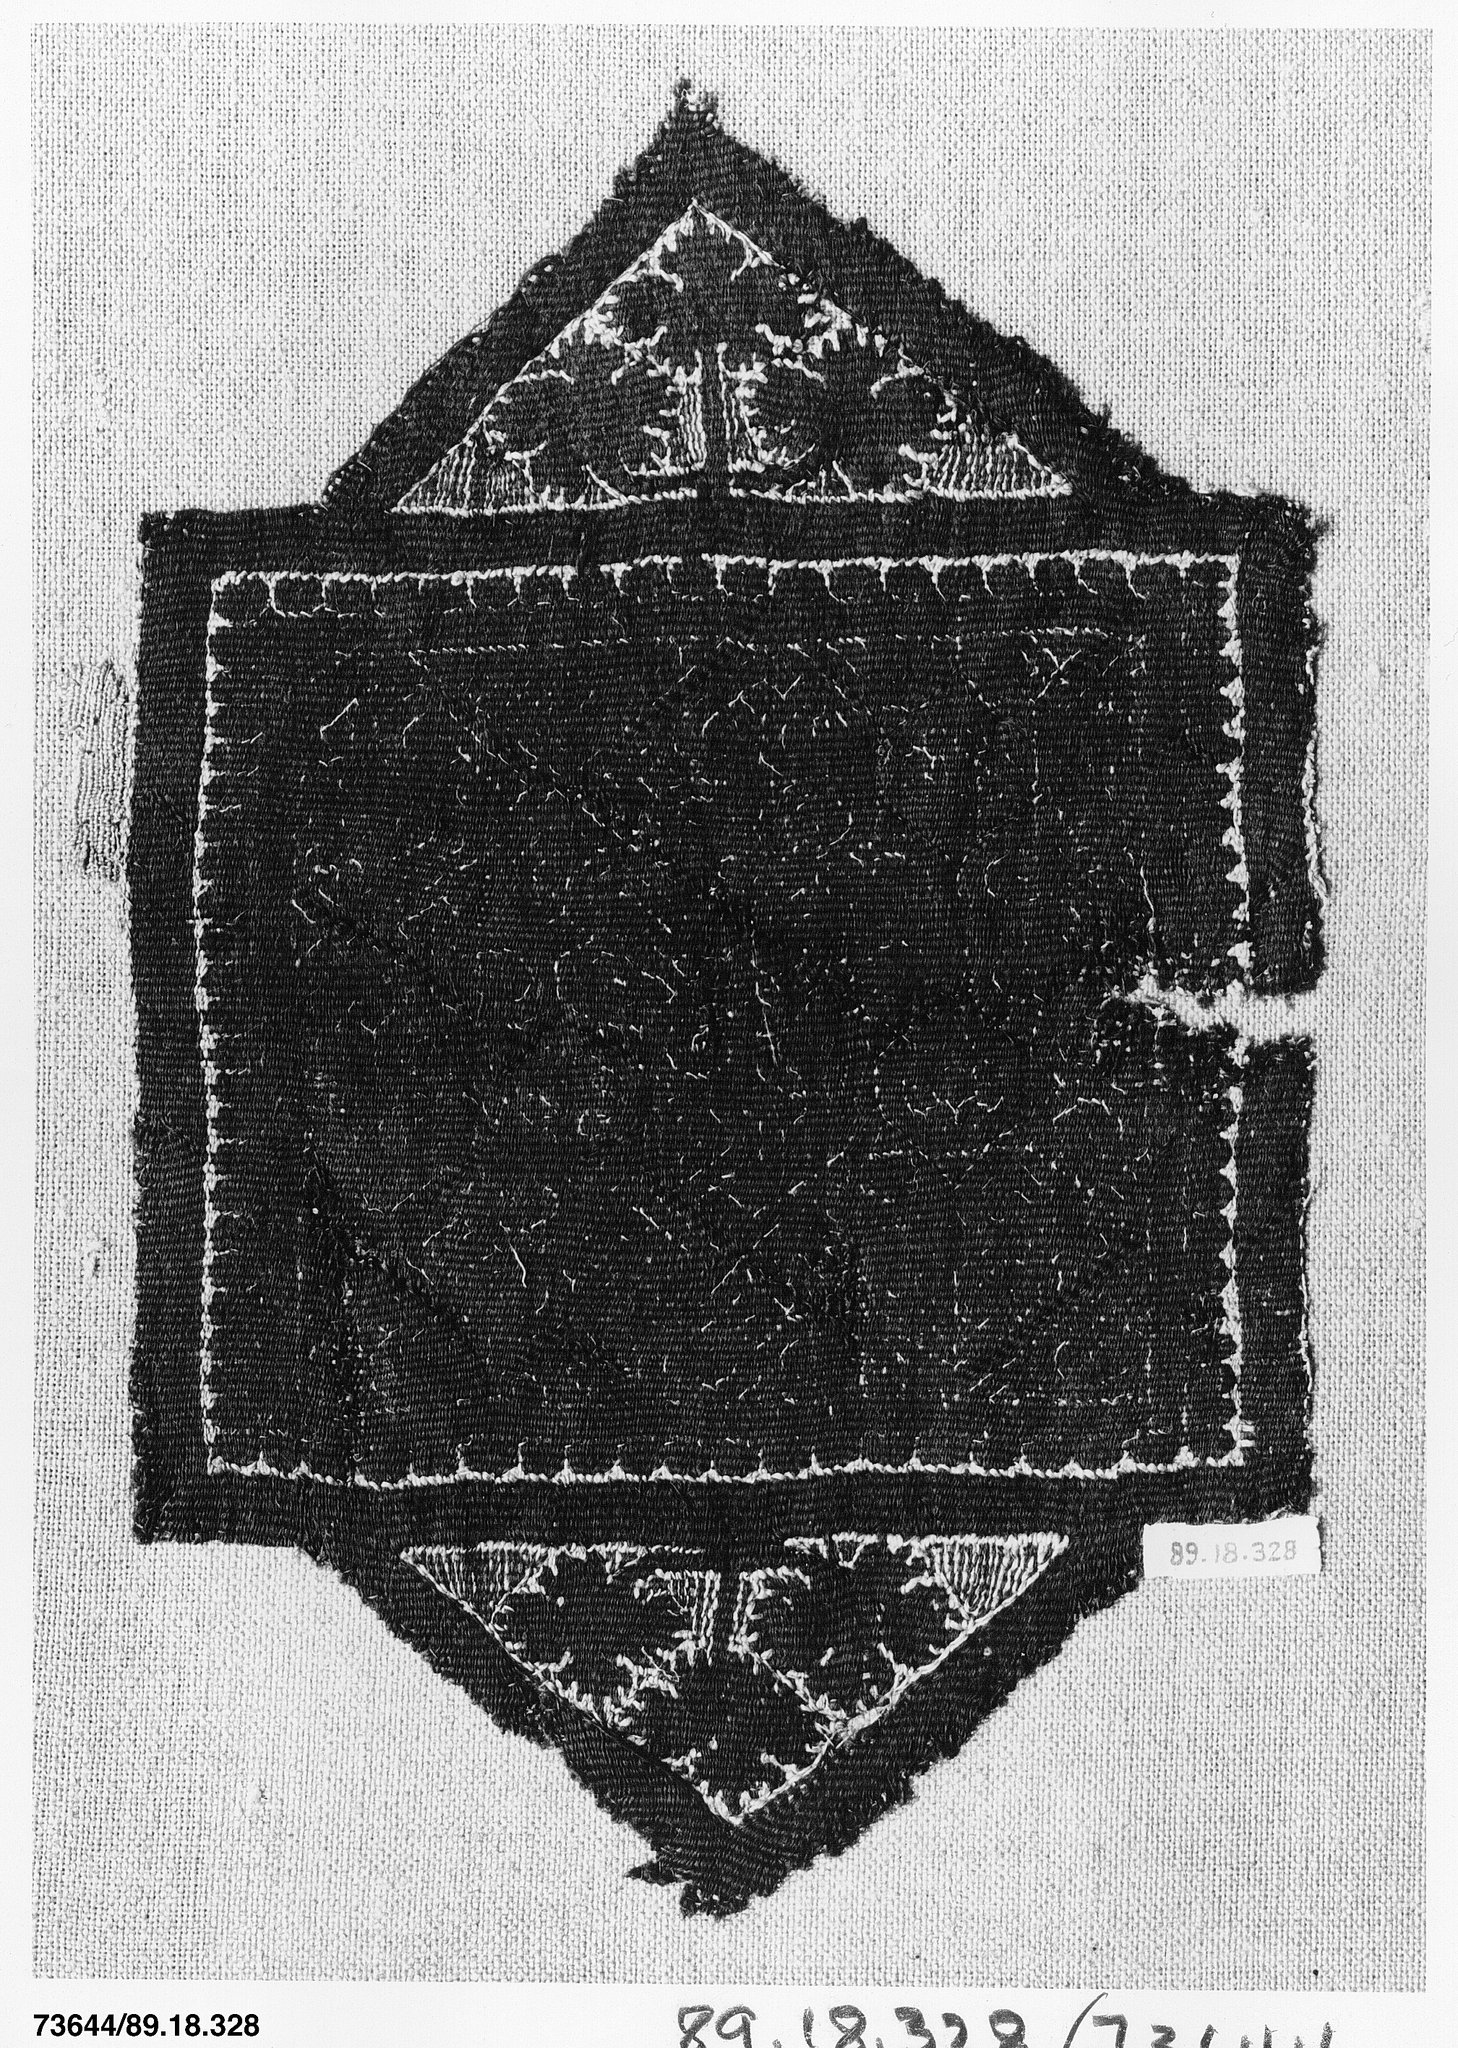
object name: textile fragment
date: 201-400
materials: linen, wool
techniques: weave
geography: egypt